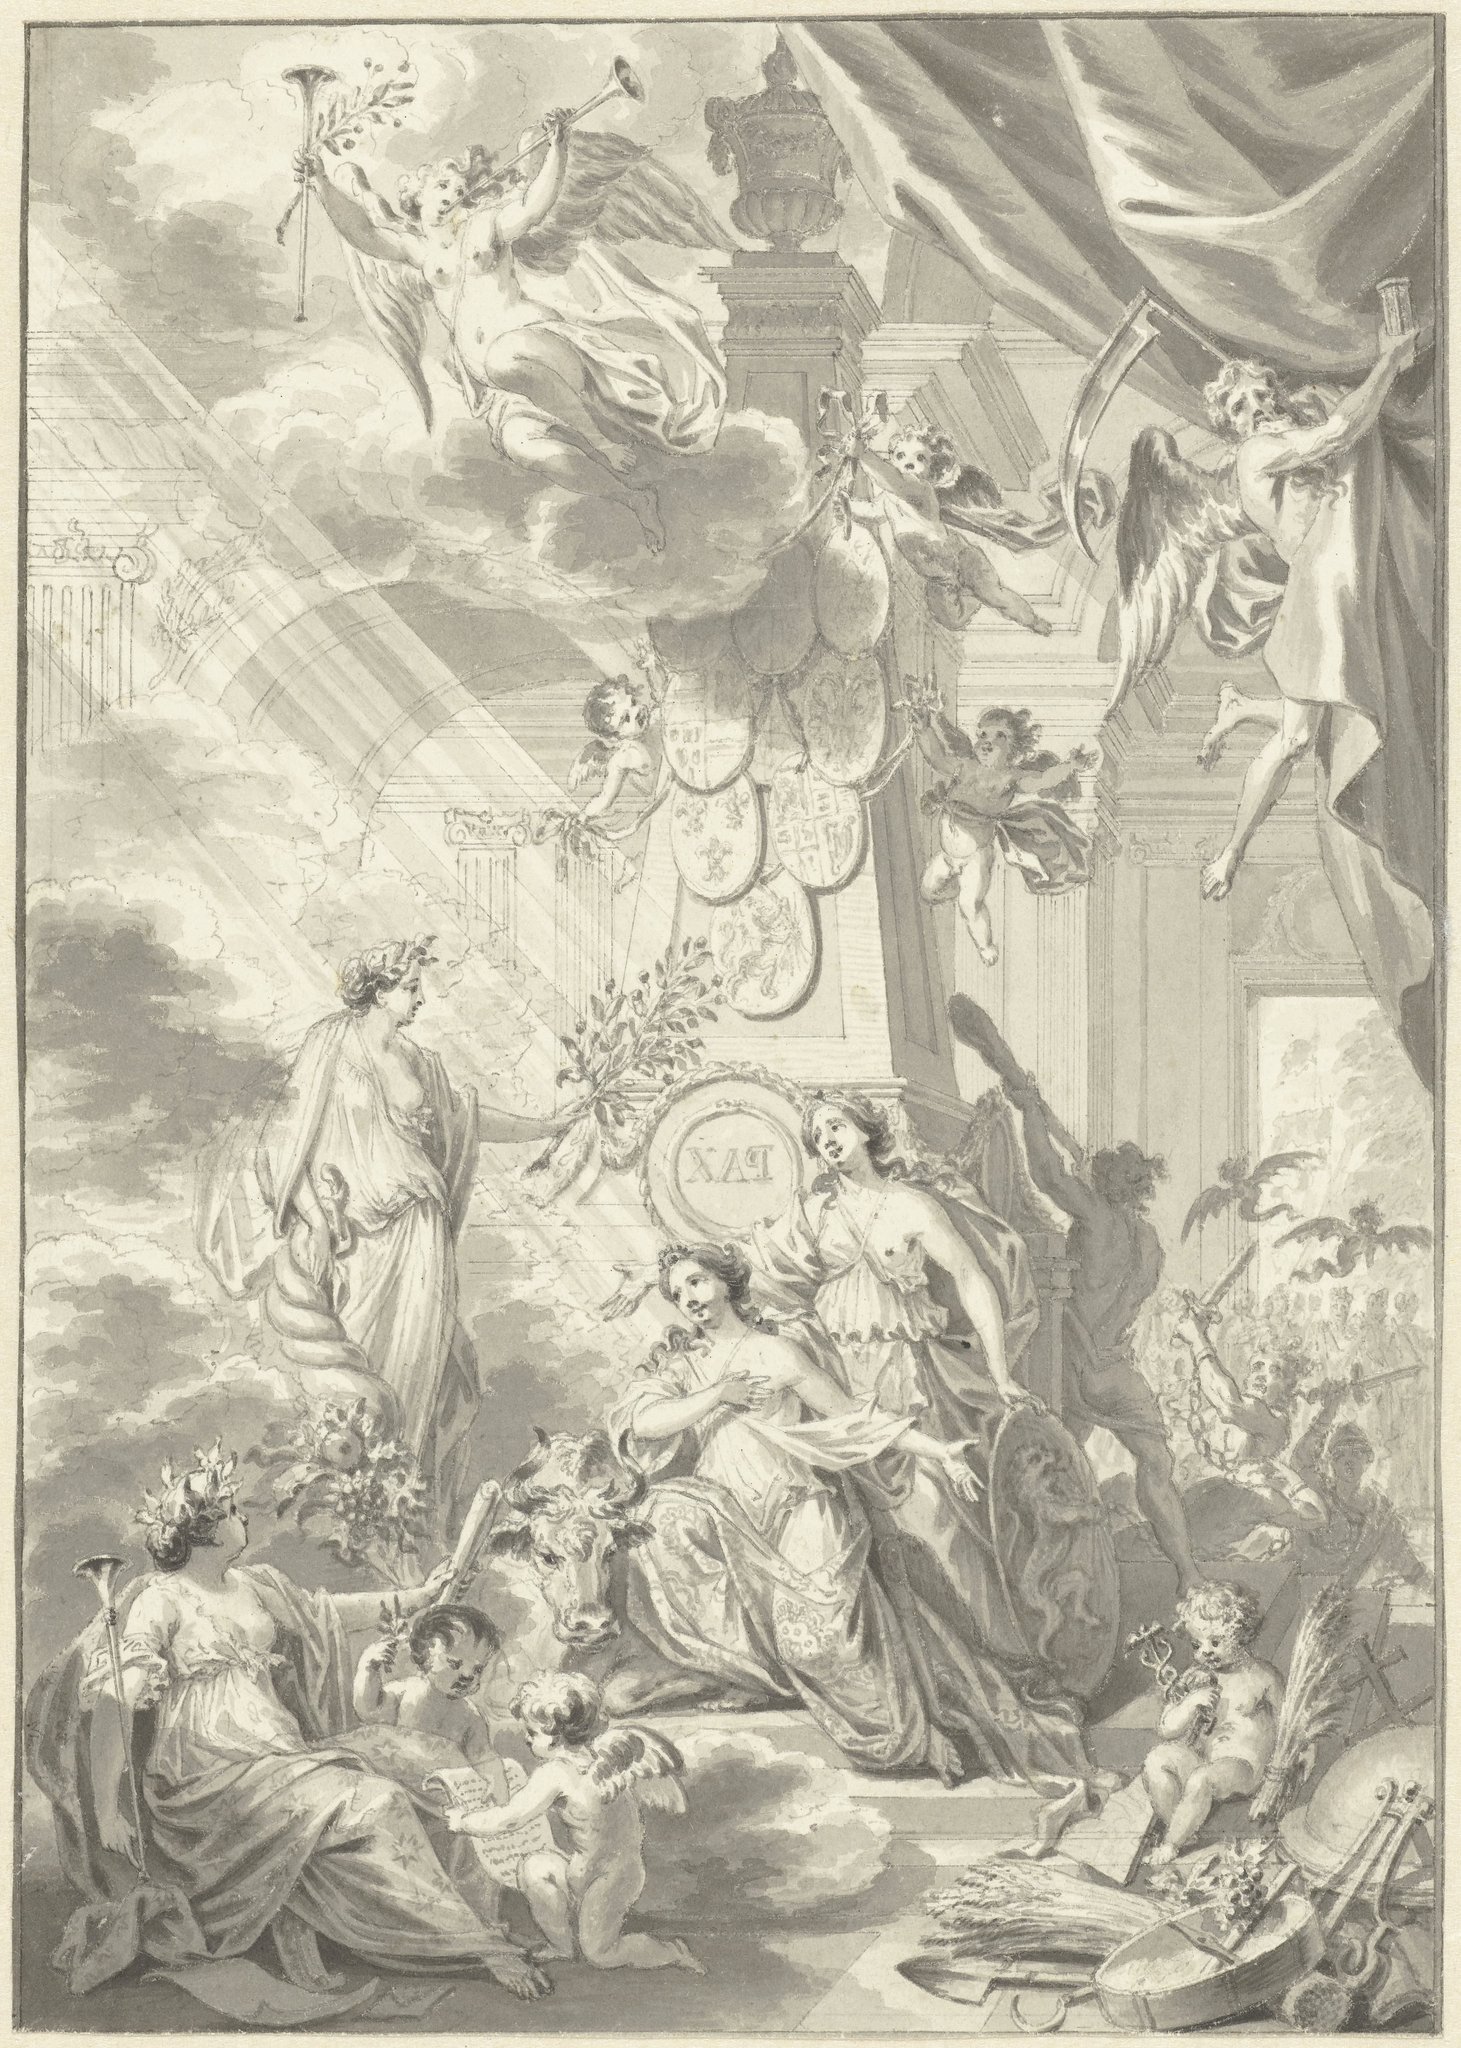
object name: design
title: Allegorie op de Vrede van Aken, 1748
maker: simon fokke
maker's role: draughtsman, print maker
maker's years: 1712-1784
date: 1749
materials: paper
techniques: pouncing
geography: northern netherlands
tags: personifications of countries, nations, states, districts, etc., symbols, allegories of peace, 'pax'; 'pace' (ripa), proclamation of peace, peace and prosperity, 'pax et abundantia', netherlands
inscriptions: collector's mark: Lugt 2228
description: Allegorie op de Vrede van Aken gesloten op 18 oktober 1748 tussen de Geallieerden (Republiek, Engeland en Oostenrijk) enerzijds en Frankrijk, Pruisen en Spanje anderzijds. Europa knielt met de stier voor de Vrede met een hoorn van overvloed, achter haar de Nederlandse Maagd, in de wolken de Faam, centraal een obelisk met wapens van de strijdende partijen. Rechts trekt Vader Tijd het gordijn opzij om het schouwspel te onthullen, op de voorgrond links de Zangkunst of Dichtkunst. Ontwerp voor een prent.